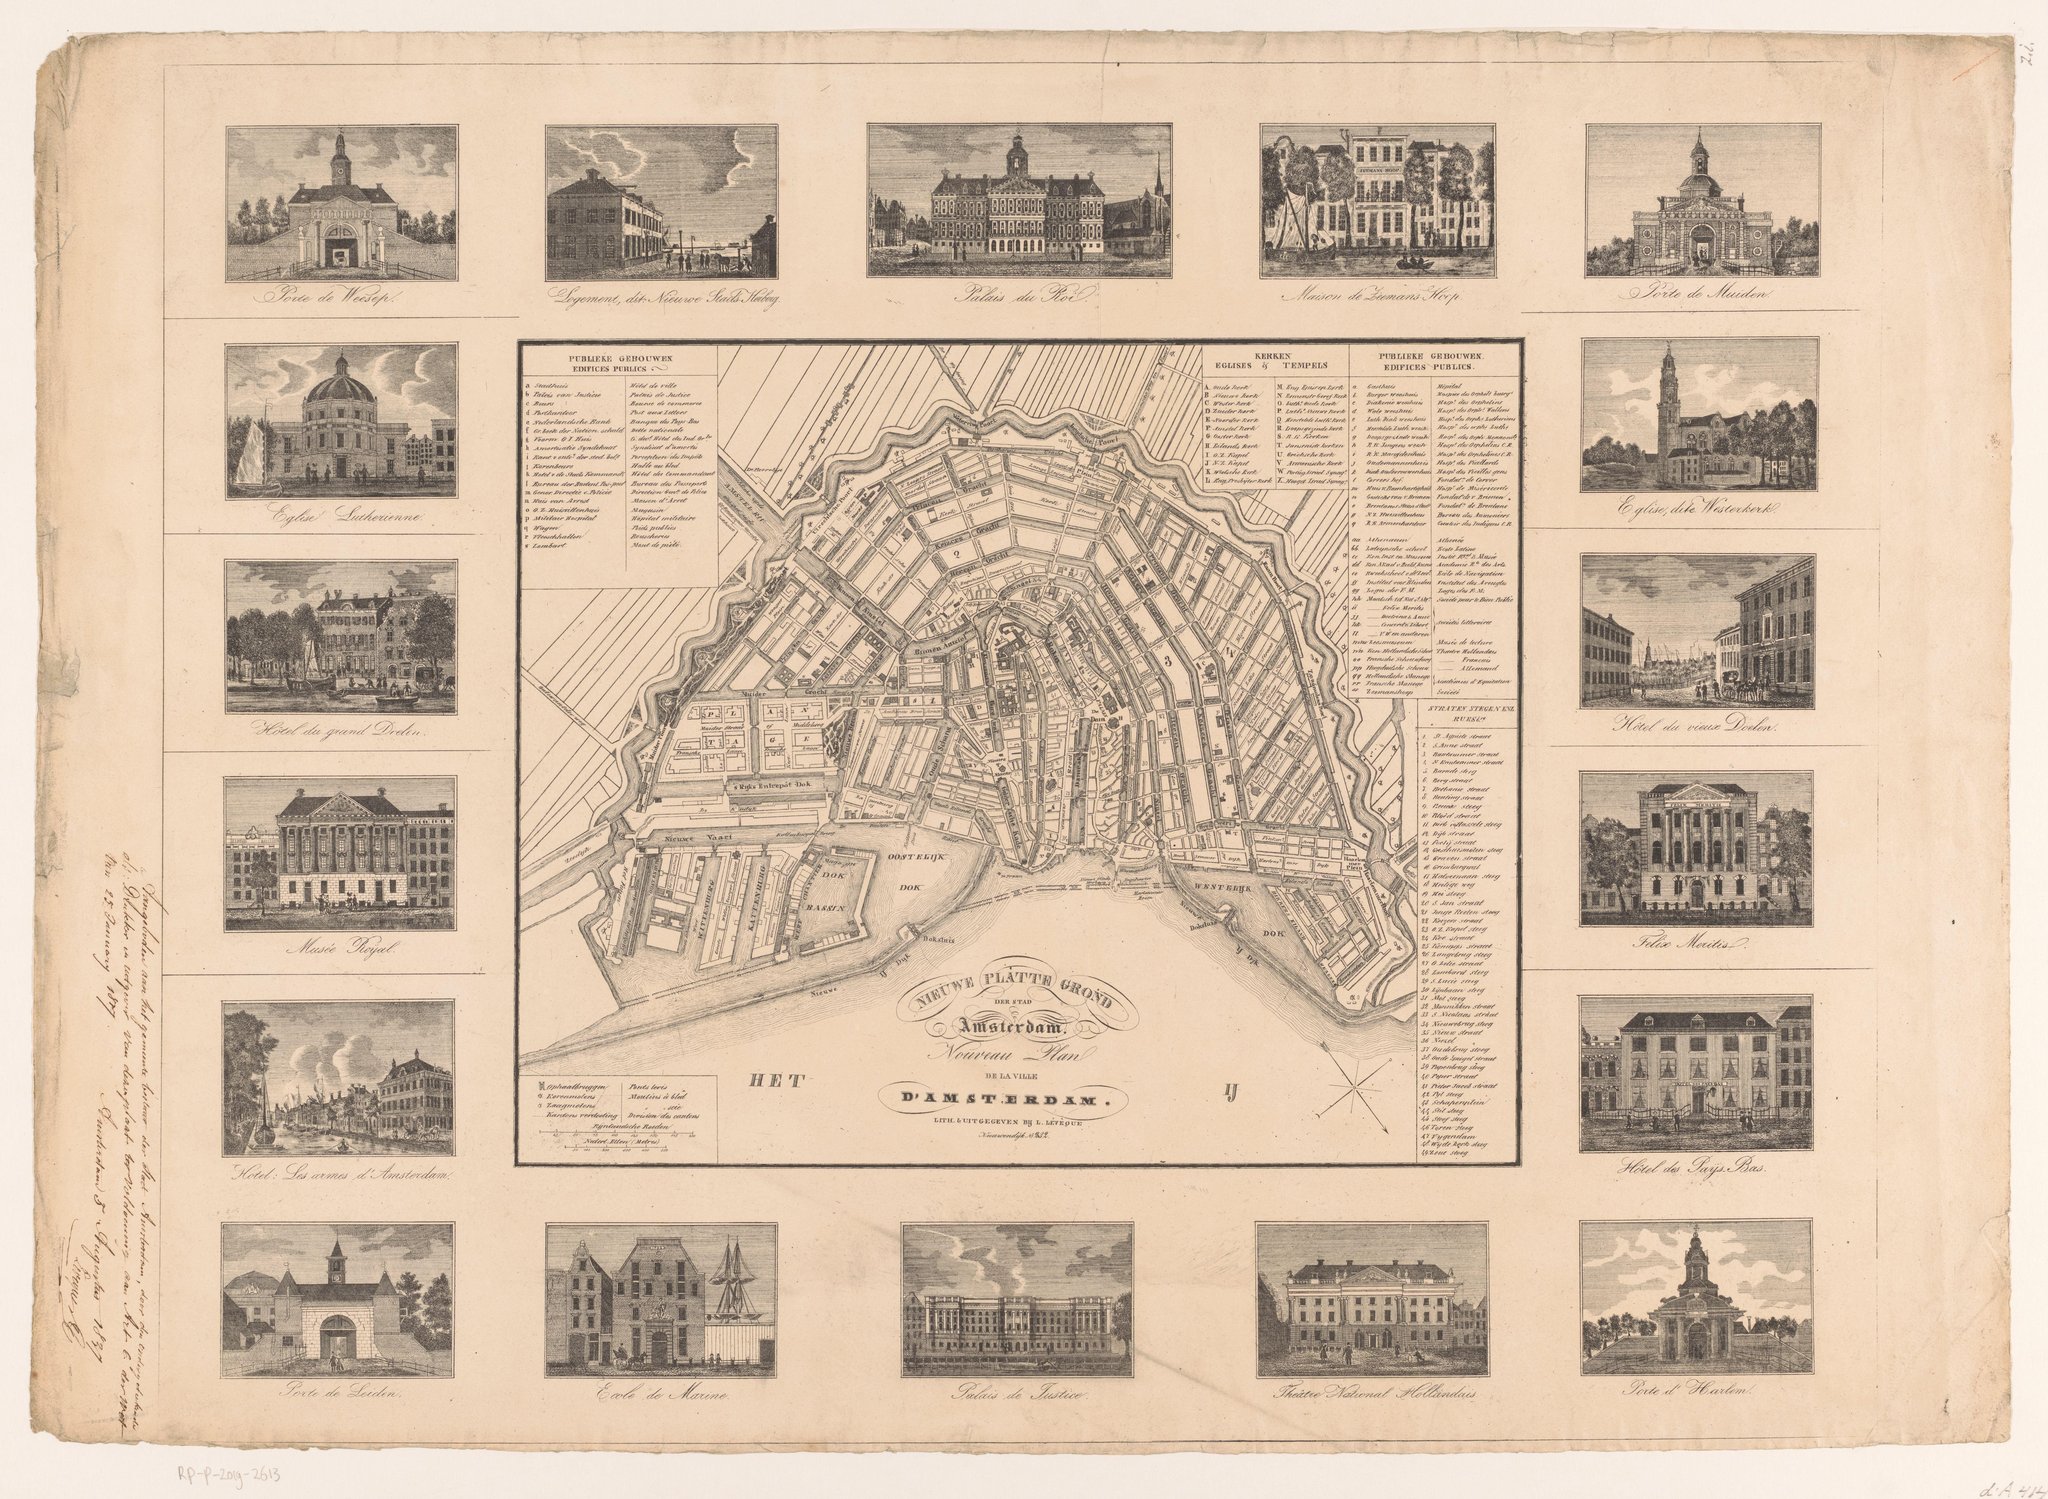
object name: area plan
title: Nieuwe platte grond der stad Amsterdam / Nouveau Plan de la Ville d'Amsterdam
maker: louis lévèque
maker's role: print maker, printer, publisher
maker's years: 1798-1878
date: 1837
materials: paper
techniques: lithograph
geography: amsterdam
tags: city-view, and landscape with man-made constructions, church (exterior), maps of cities, royal palace of amsterdam, amsterdam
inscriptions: inscription: ‘Aangeboden aan het gemeente bestuur der Stadt Amsterdam, door den ondergetekende als: Drukker en uitgever van dezen plaat ter voldoening aan Art. 6 der Wet van 25 January 1807. Amsterdam 5 augustus 1837, Leveque’